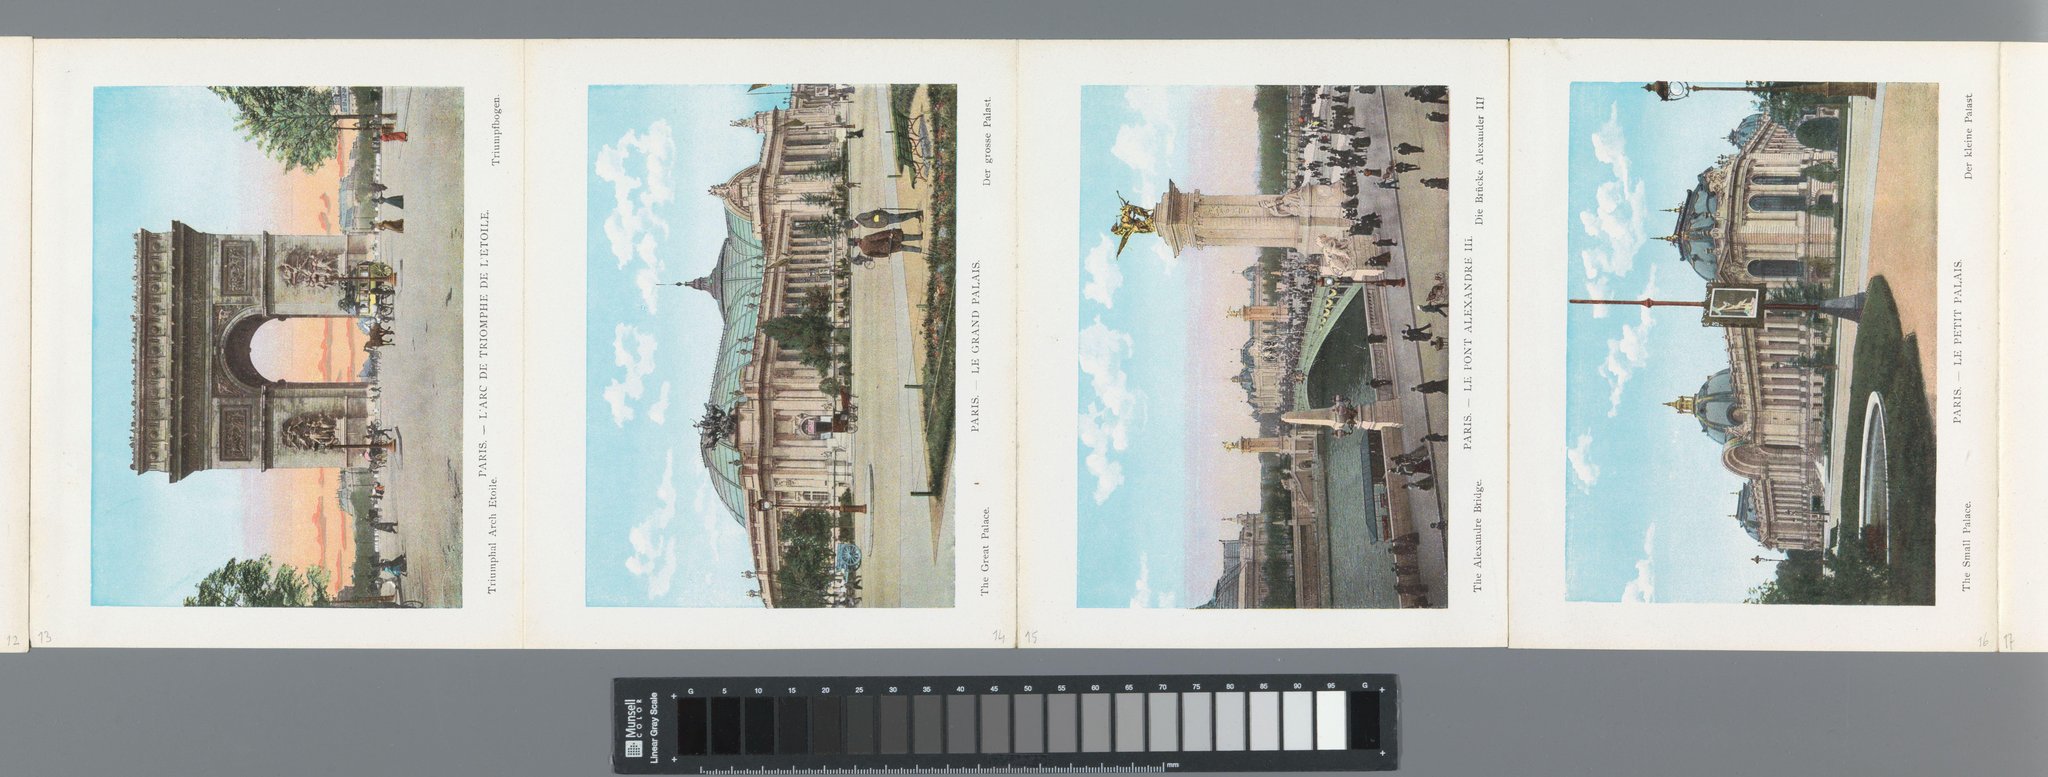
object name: page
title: Gezicht op het Grand Palais in Parijs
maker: Anonymous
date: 1900-1930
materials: cardboard, paper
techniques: autotype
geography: paris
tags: palace, travelling; tourism, permanent exhibition, museum, prospect of city, town panorama, silhouette of city, paris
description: Onderdeel van Fotoalbum met kleurenopnames van bezienswaardigheden in Parijs.